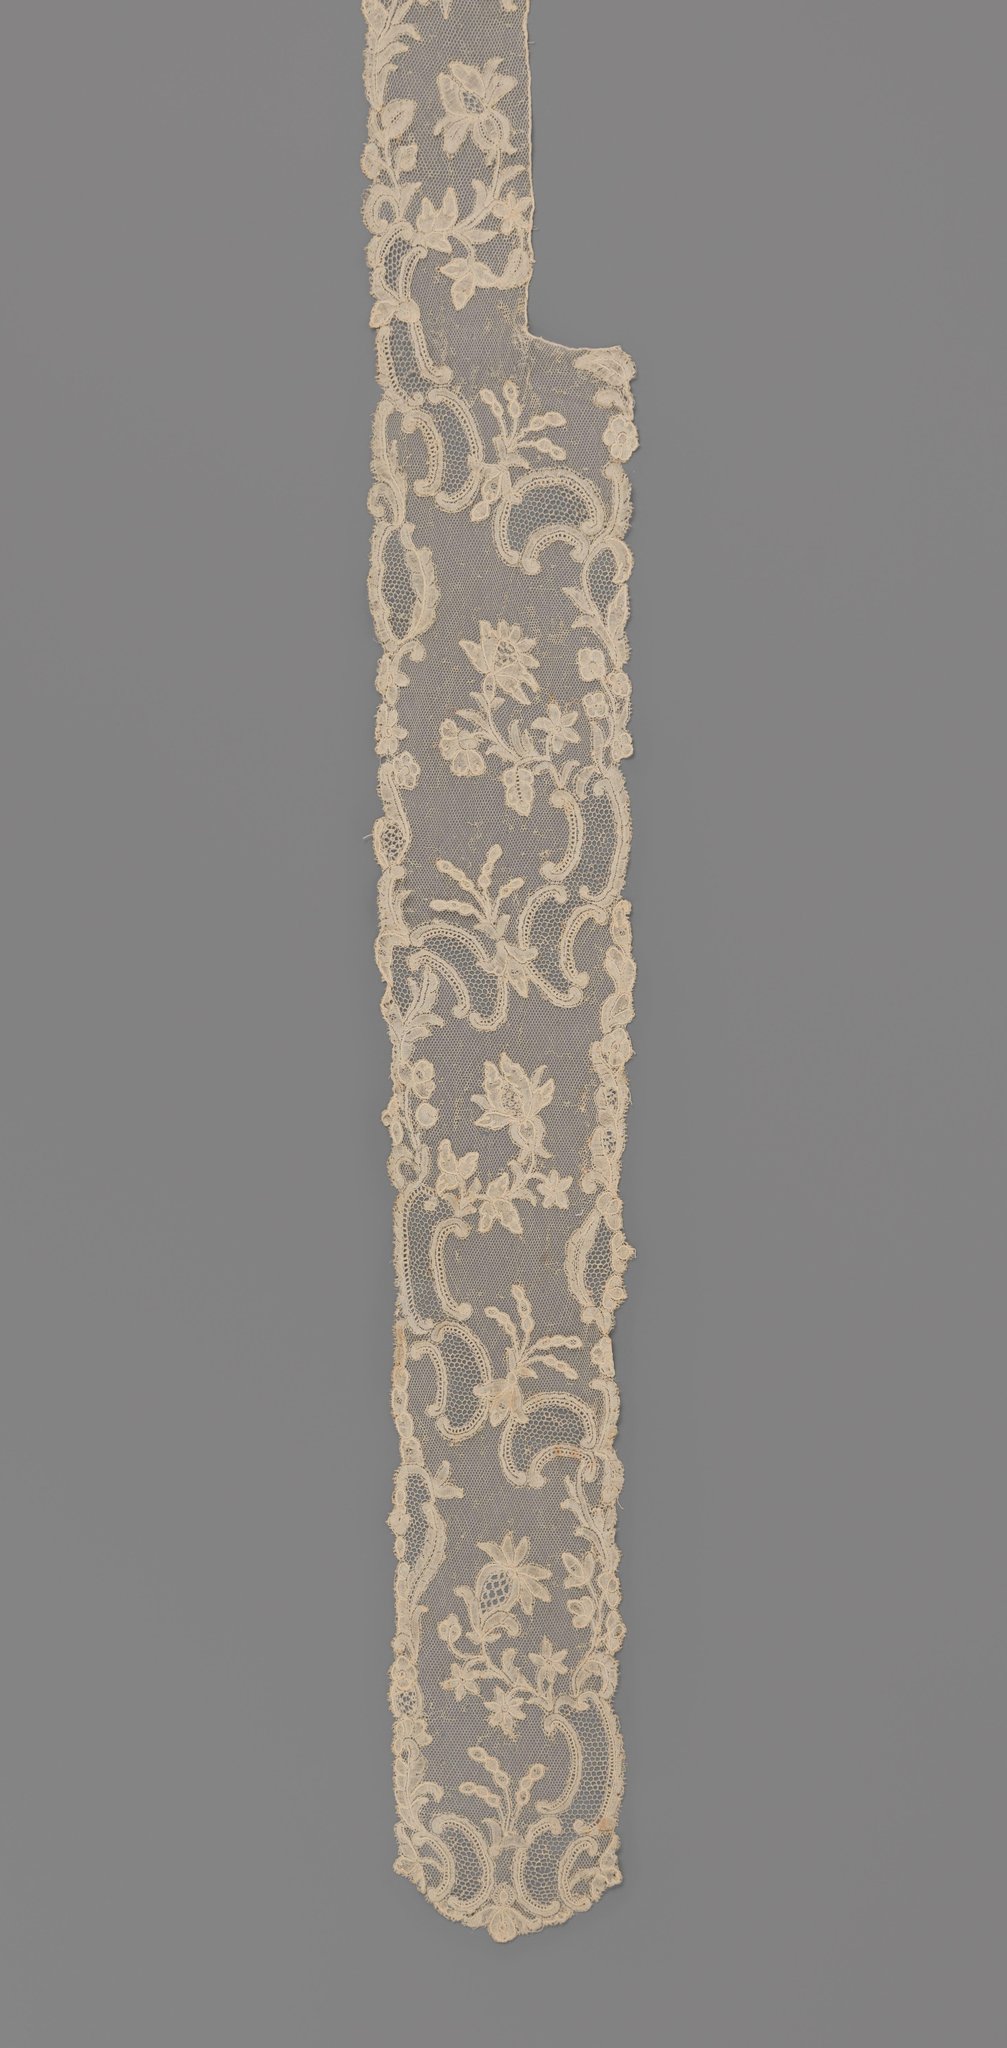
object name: lappet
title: Mutsenslip en een deel van een voorhoofdstrook van Brusselse kloskant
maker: Anonymous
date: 1750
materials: lace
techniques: lace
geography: brussels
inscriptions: label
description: Mutsenslip en een deel van een voorhoofdstrook van Brusselse kloskant. De mutsenslip heeft een rond uiteinde, is licht geschulpt en voorzien van een picotrand. De decoratie bestaat uit c-vormige voluten en bloemtakken.